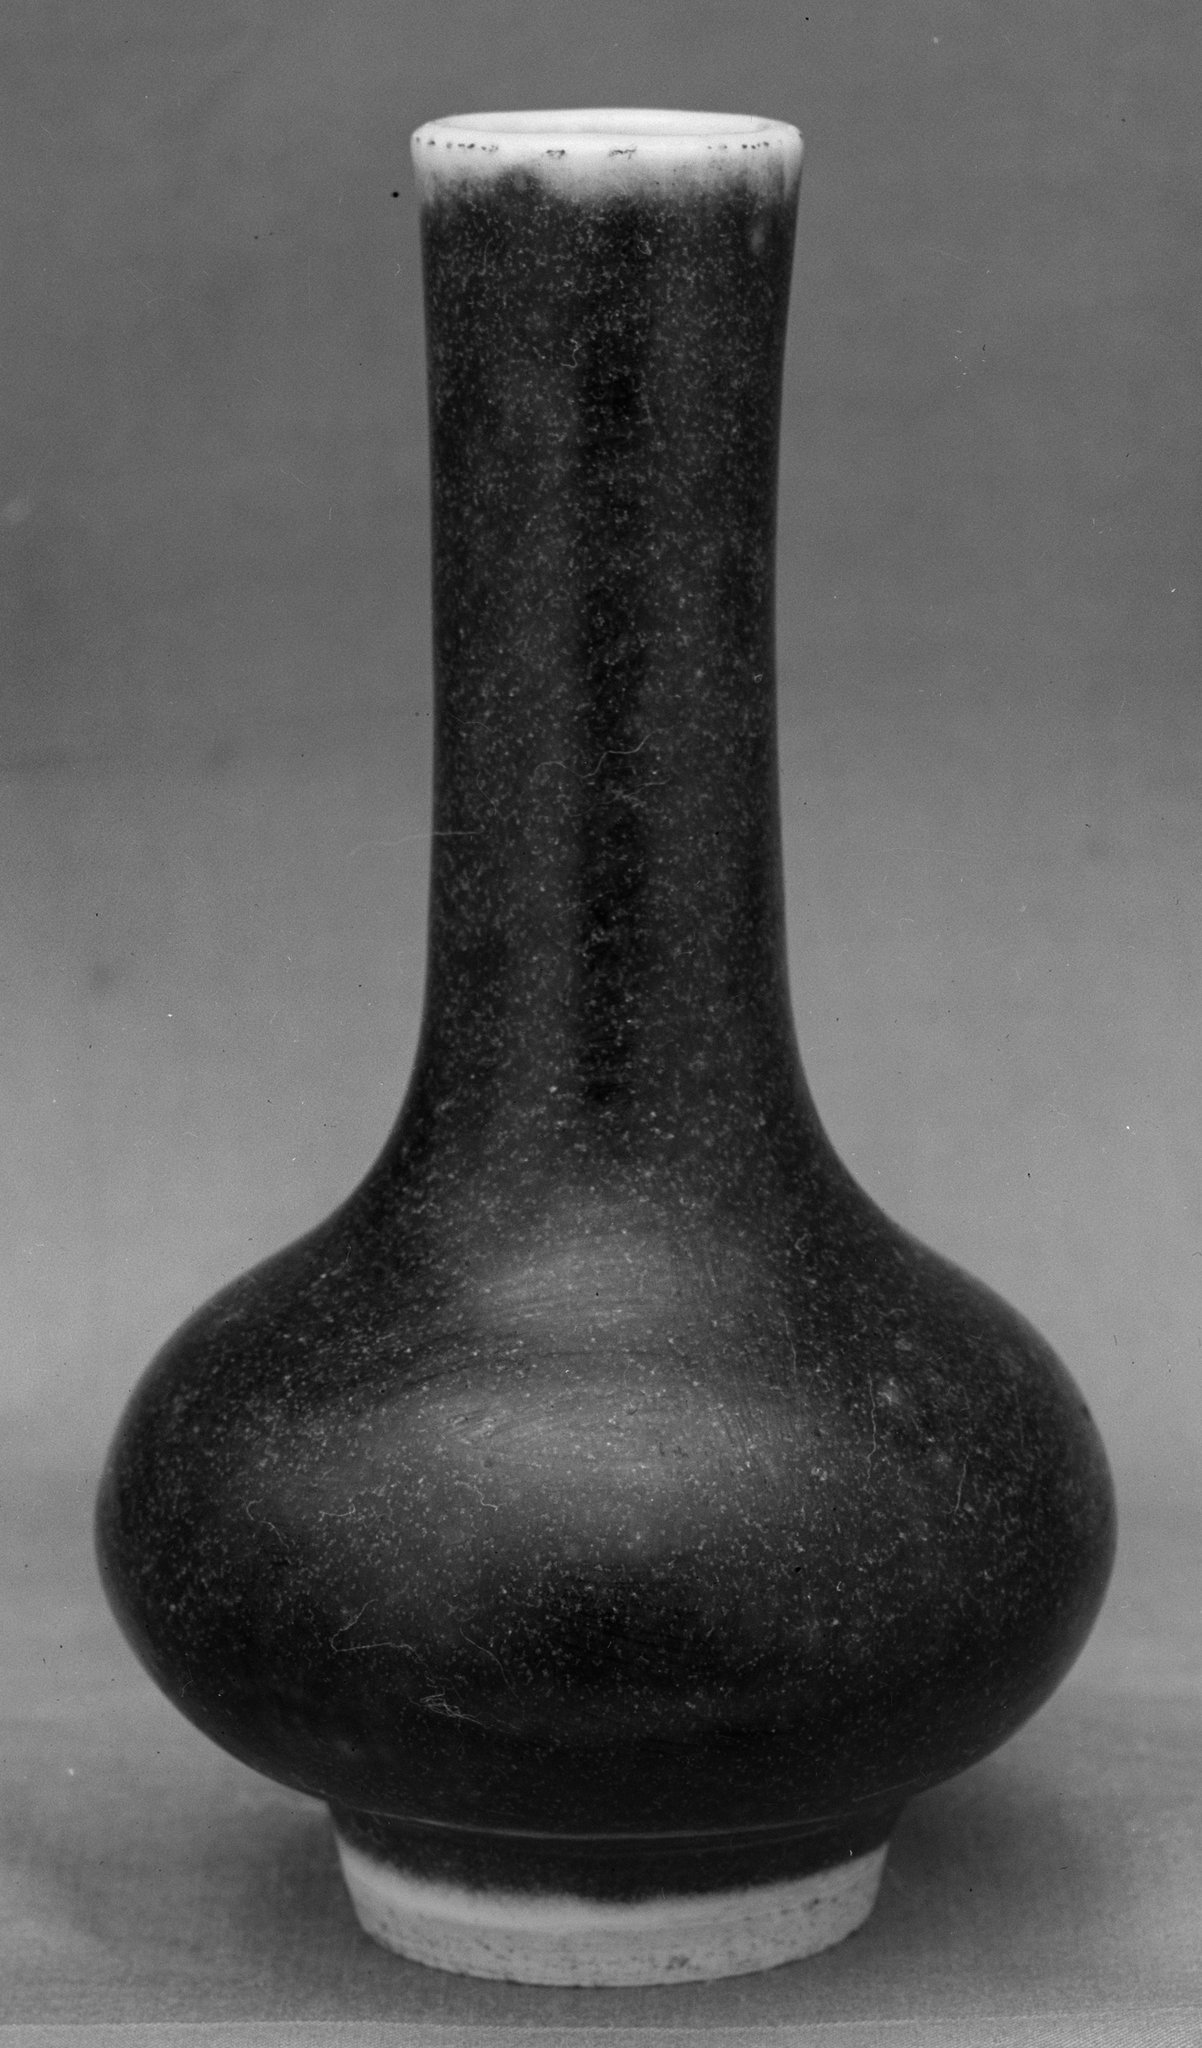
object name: bottle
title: Miniature Bottle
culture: chinese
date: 1662-1722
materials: glaze, porcelain